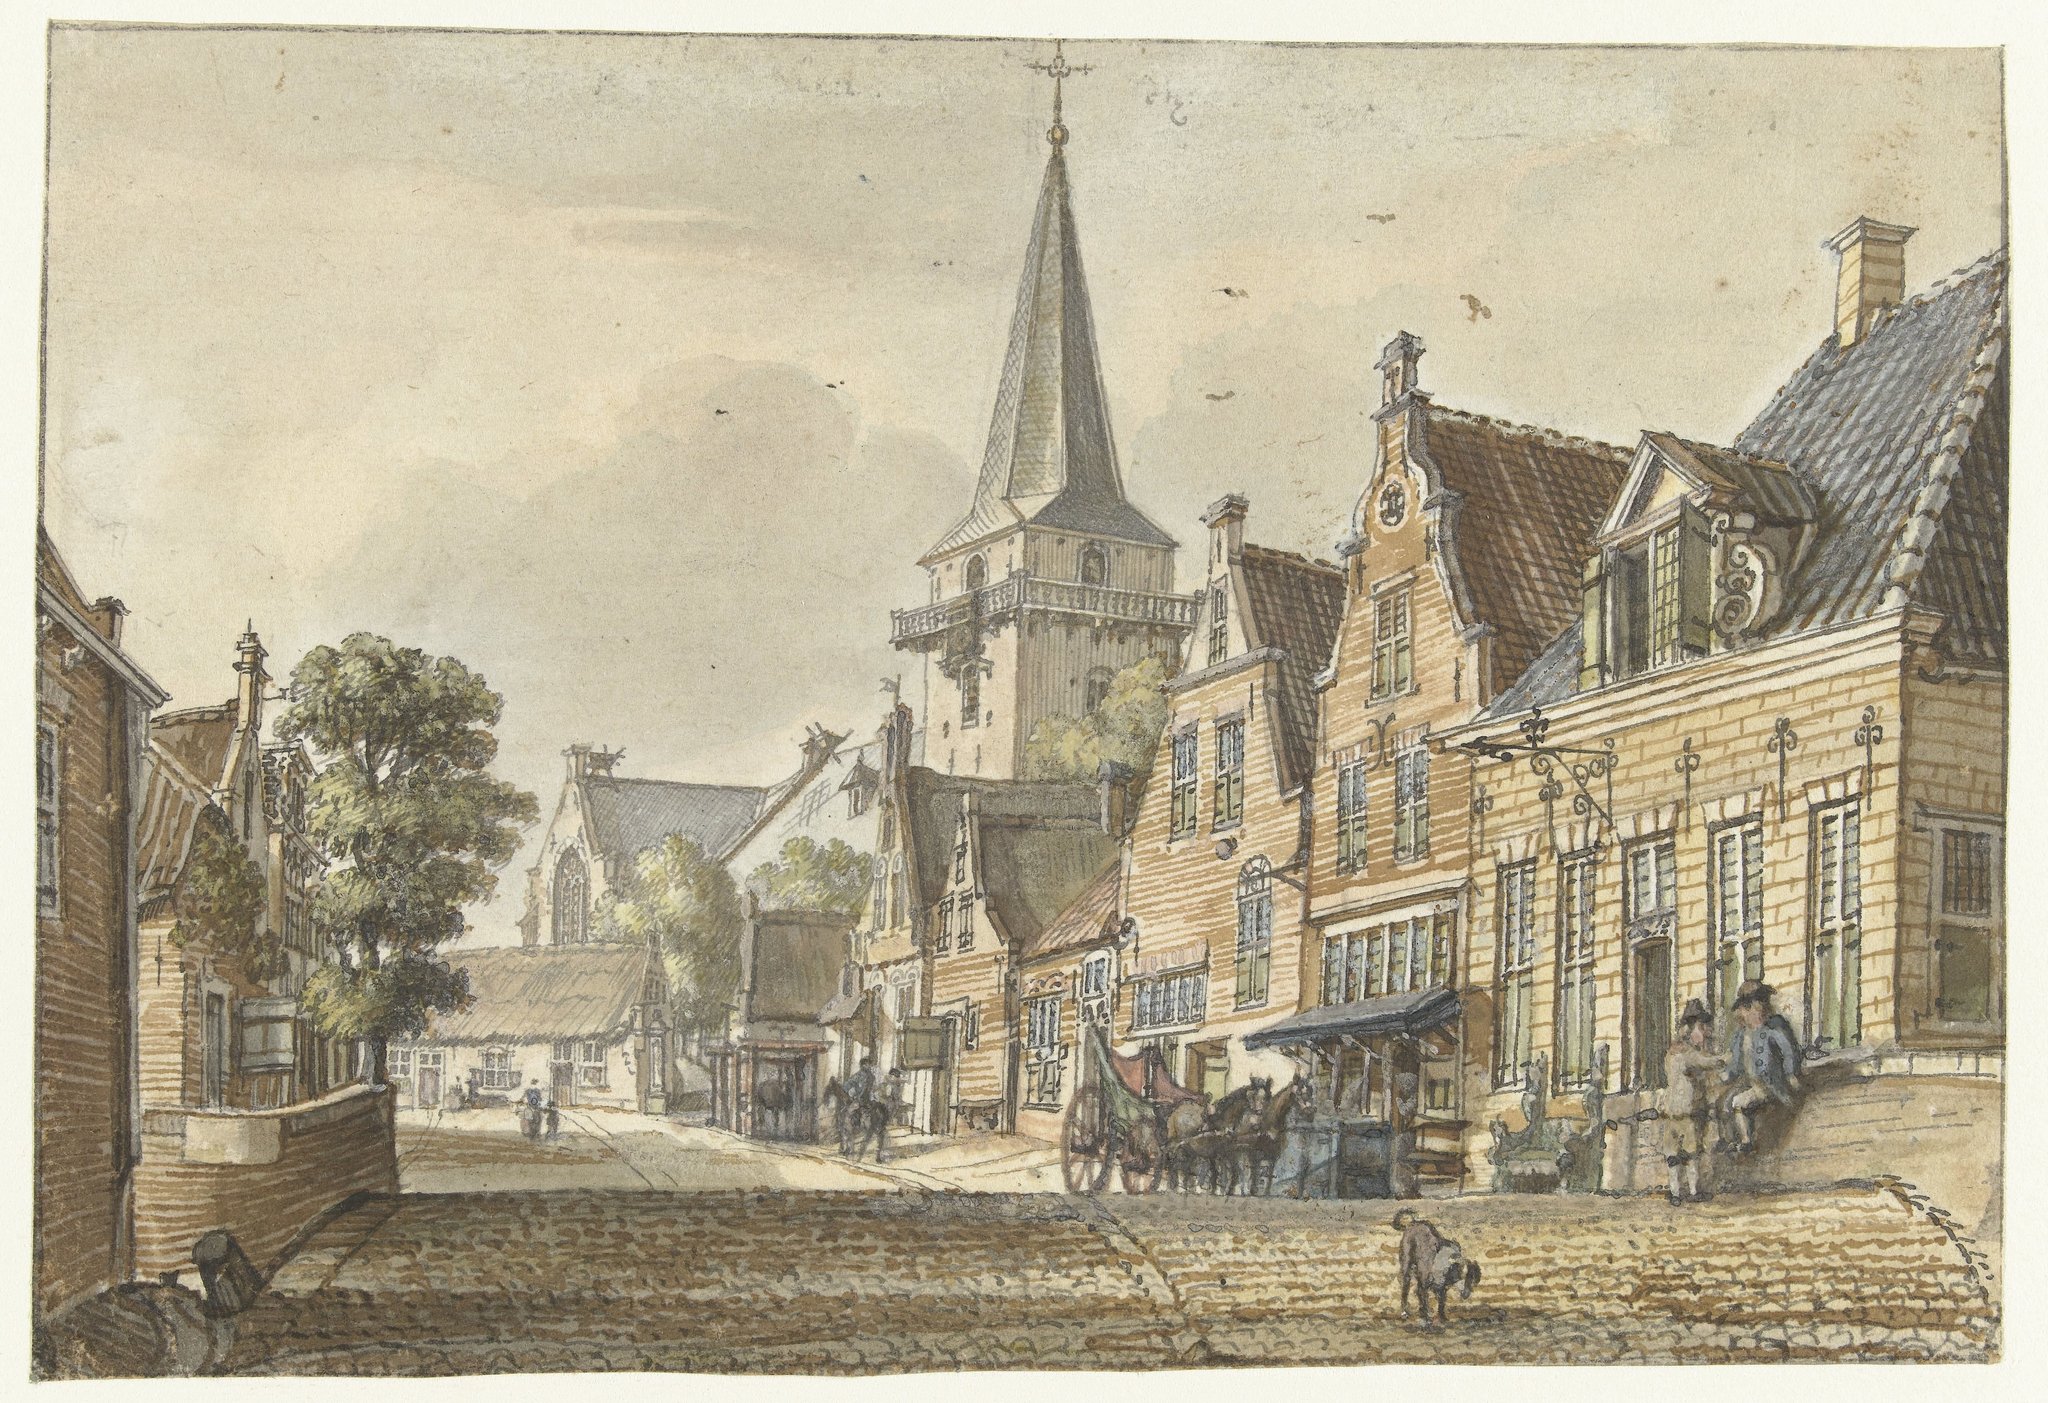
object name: drawing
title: Gezicht in het dorp Harmelen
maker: jan de beijer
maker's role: draughtsman, print maker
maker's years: 1703-1780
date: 1749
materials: paint, ink, paper, watercolor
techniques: brush, pen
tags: prospect of city, town panorama, silhouette of city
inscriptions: date: ‘23 Augustus 1749’